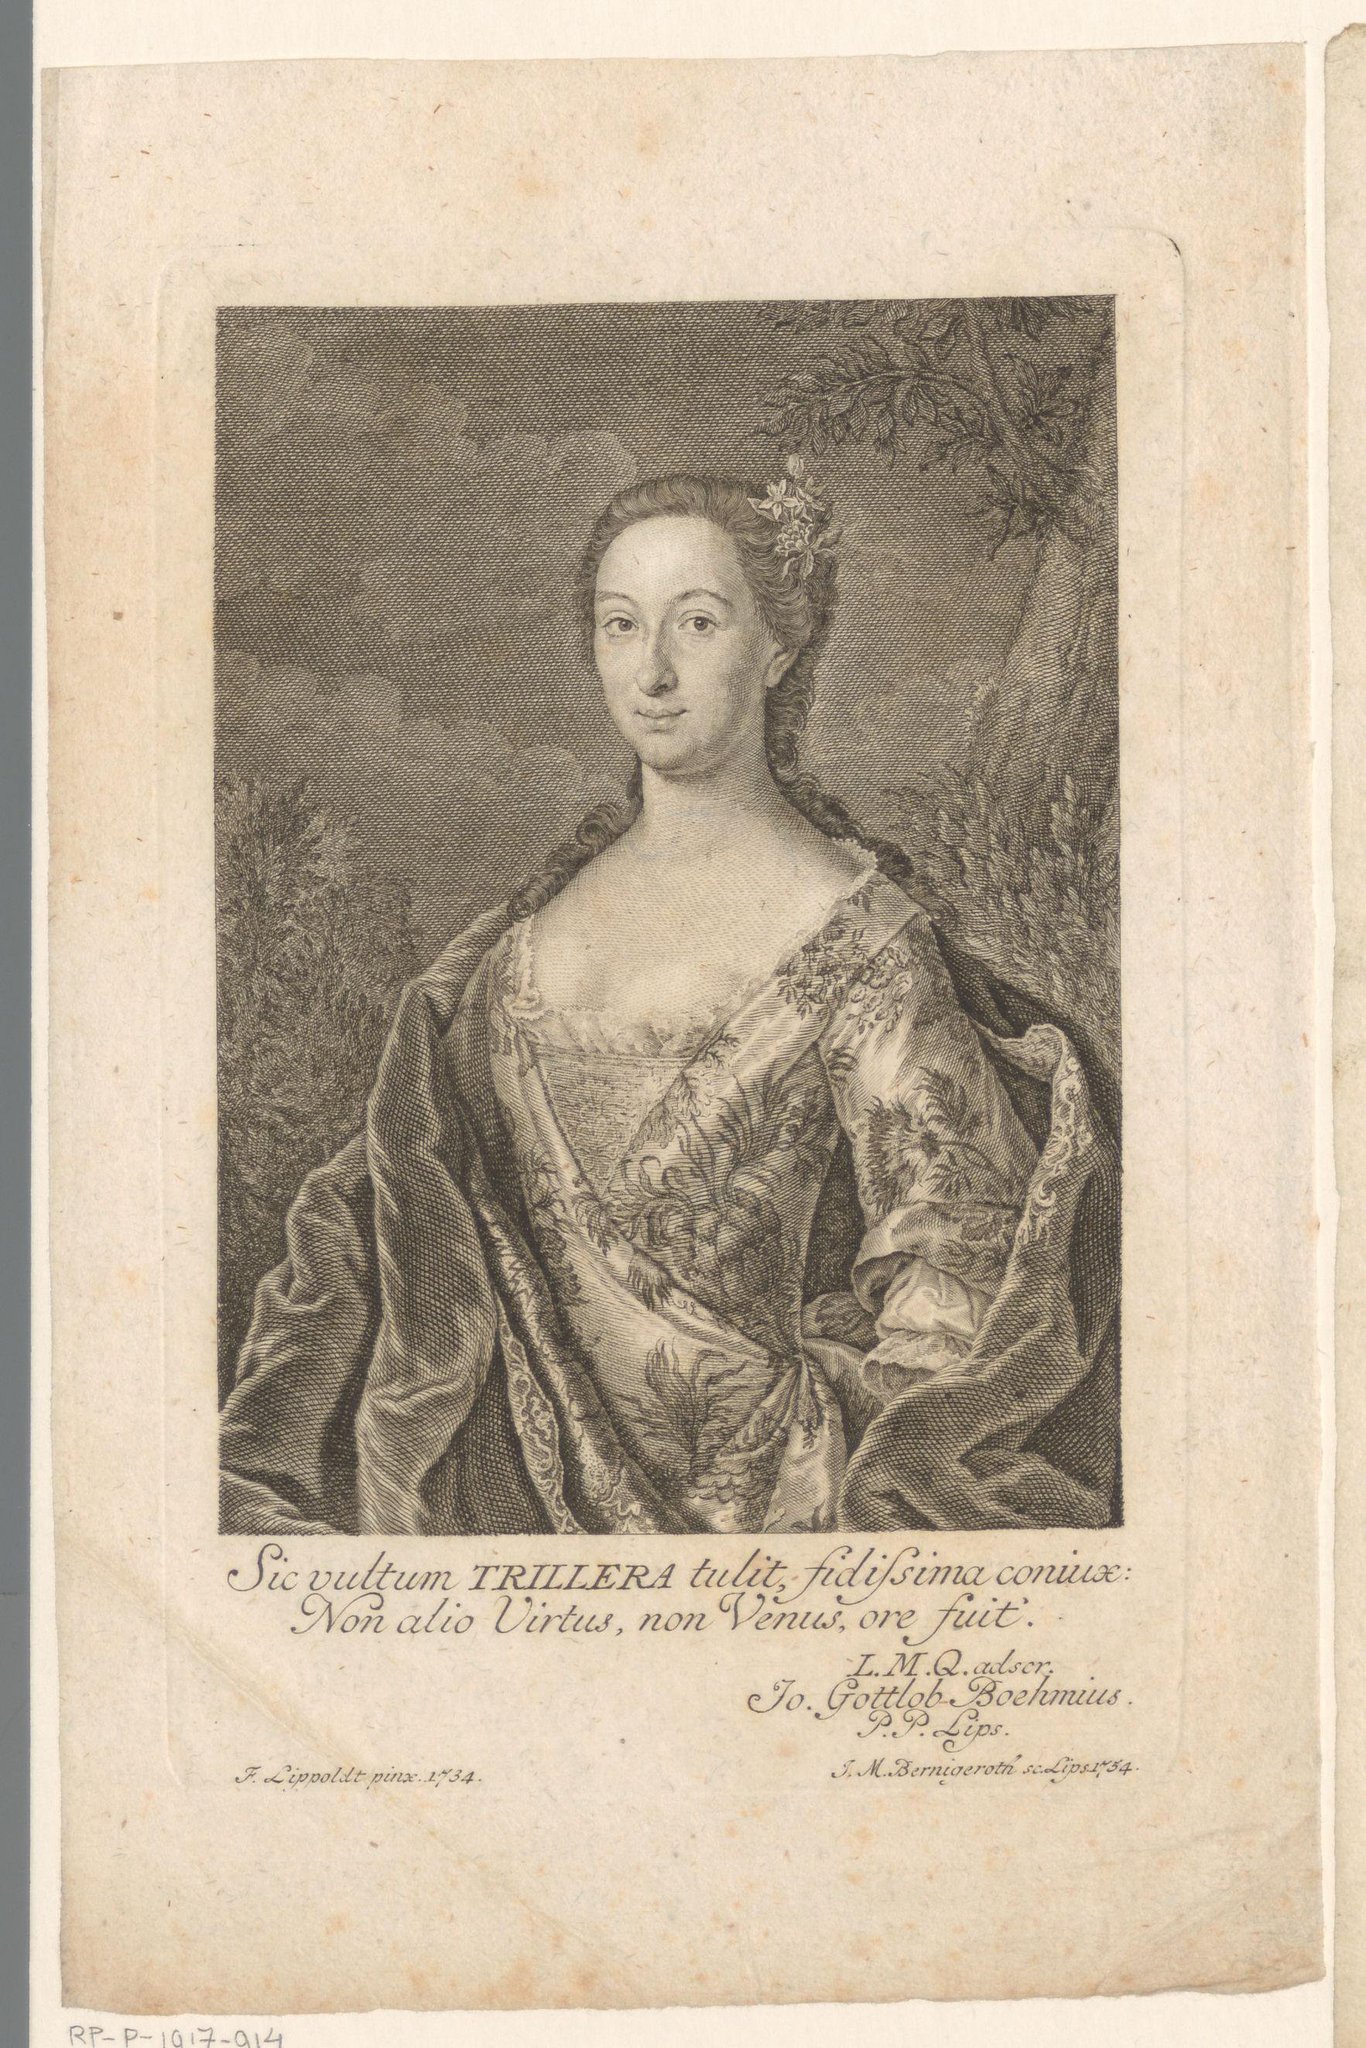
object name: print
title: Portret van Henriette Triller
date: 1754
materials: paper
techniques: engraving, etching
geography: leipzig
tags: henriette triller, historical persons - bb - woman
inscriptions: collector's mark: Lugt 2228